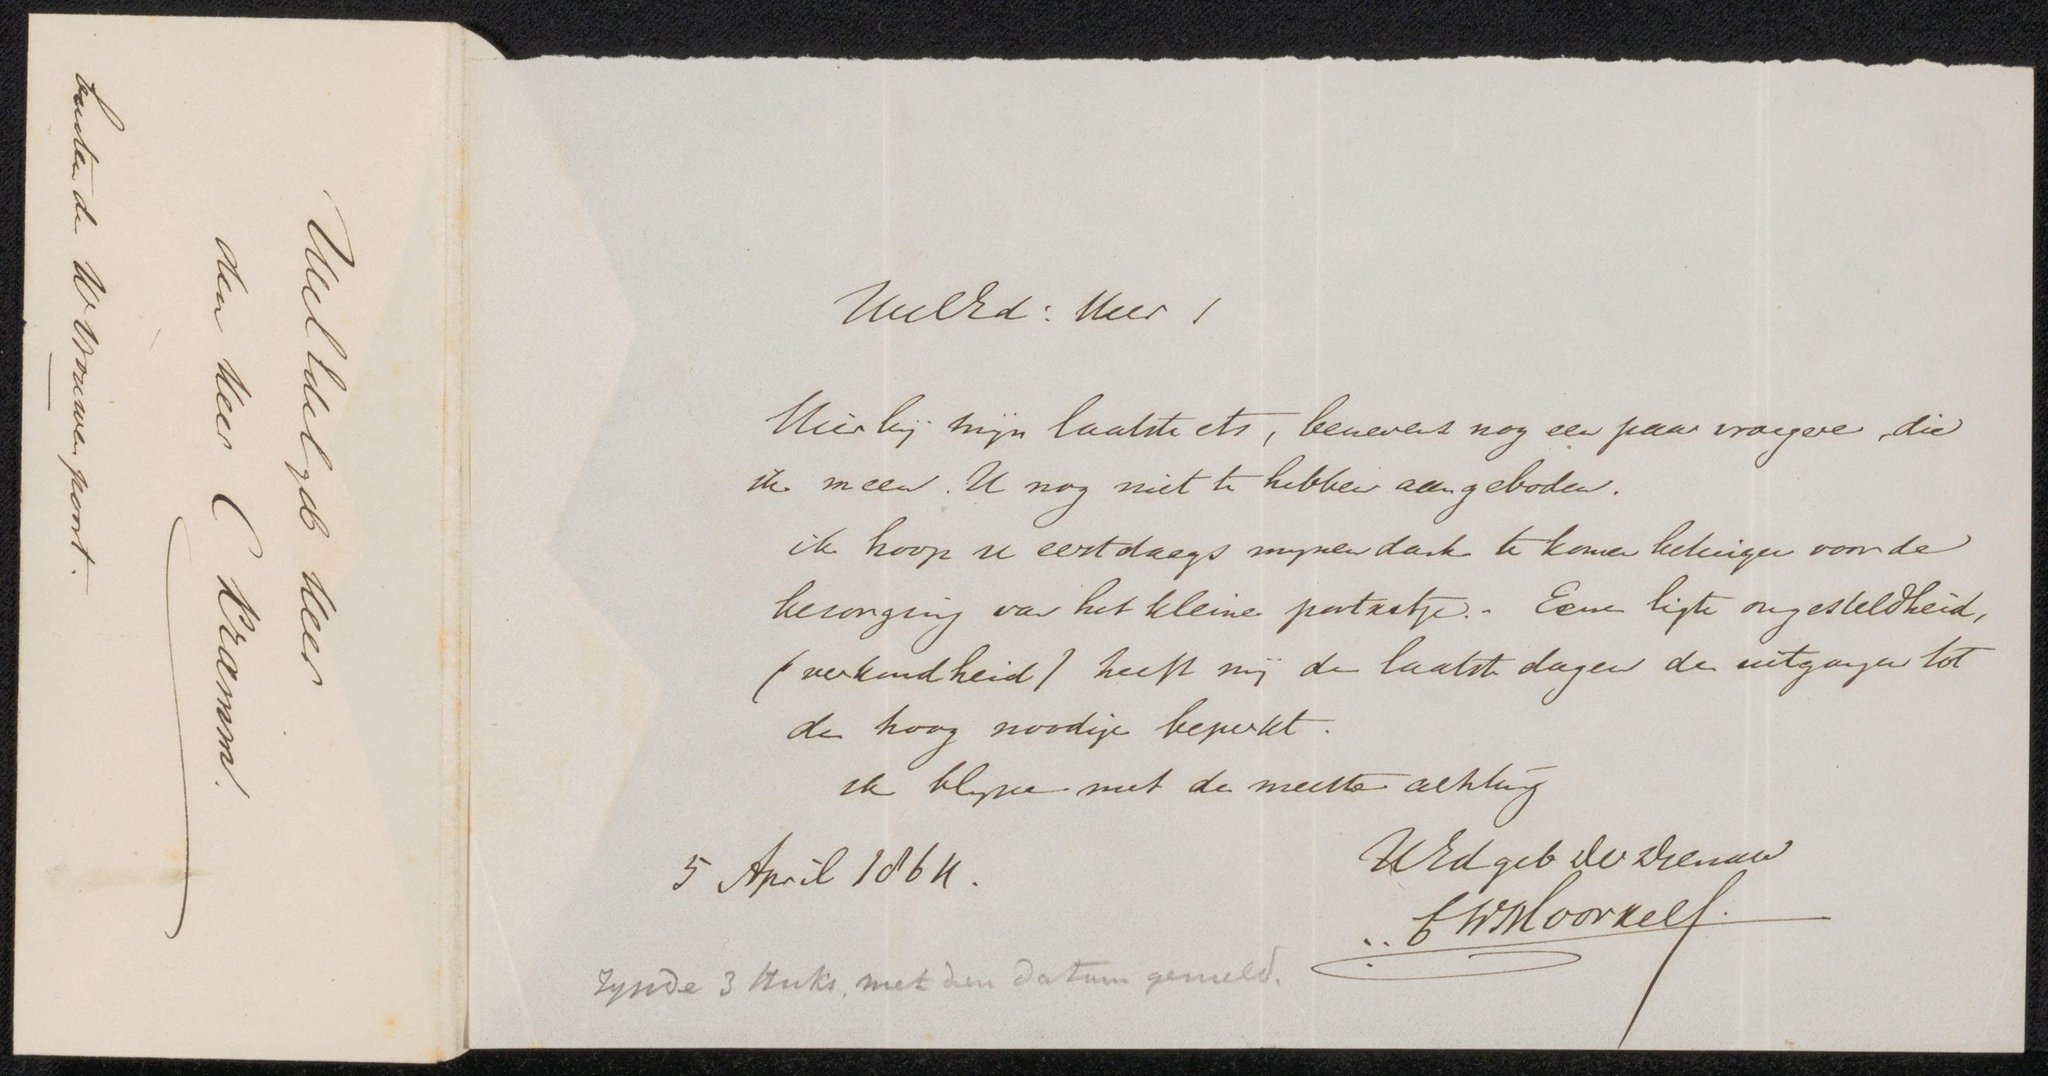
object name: letter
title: Brief aan Christiaan Kramm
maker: christiaan wilhelmus moorrees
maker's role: draughtsman, print maker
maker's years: 1801-1867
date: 1864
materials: ink, paper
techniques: pen, writing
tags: utrecht, print maker, draughtsman, christiaan kramm, the graphic arts, diseases, historical persons (portraits and scenes from the life)